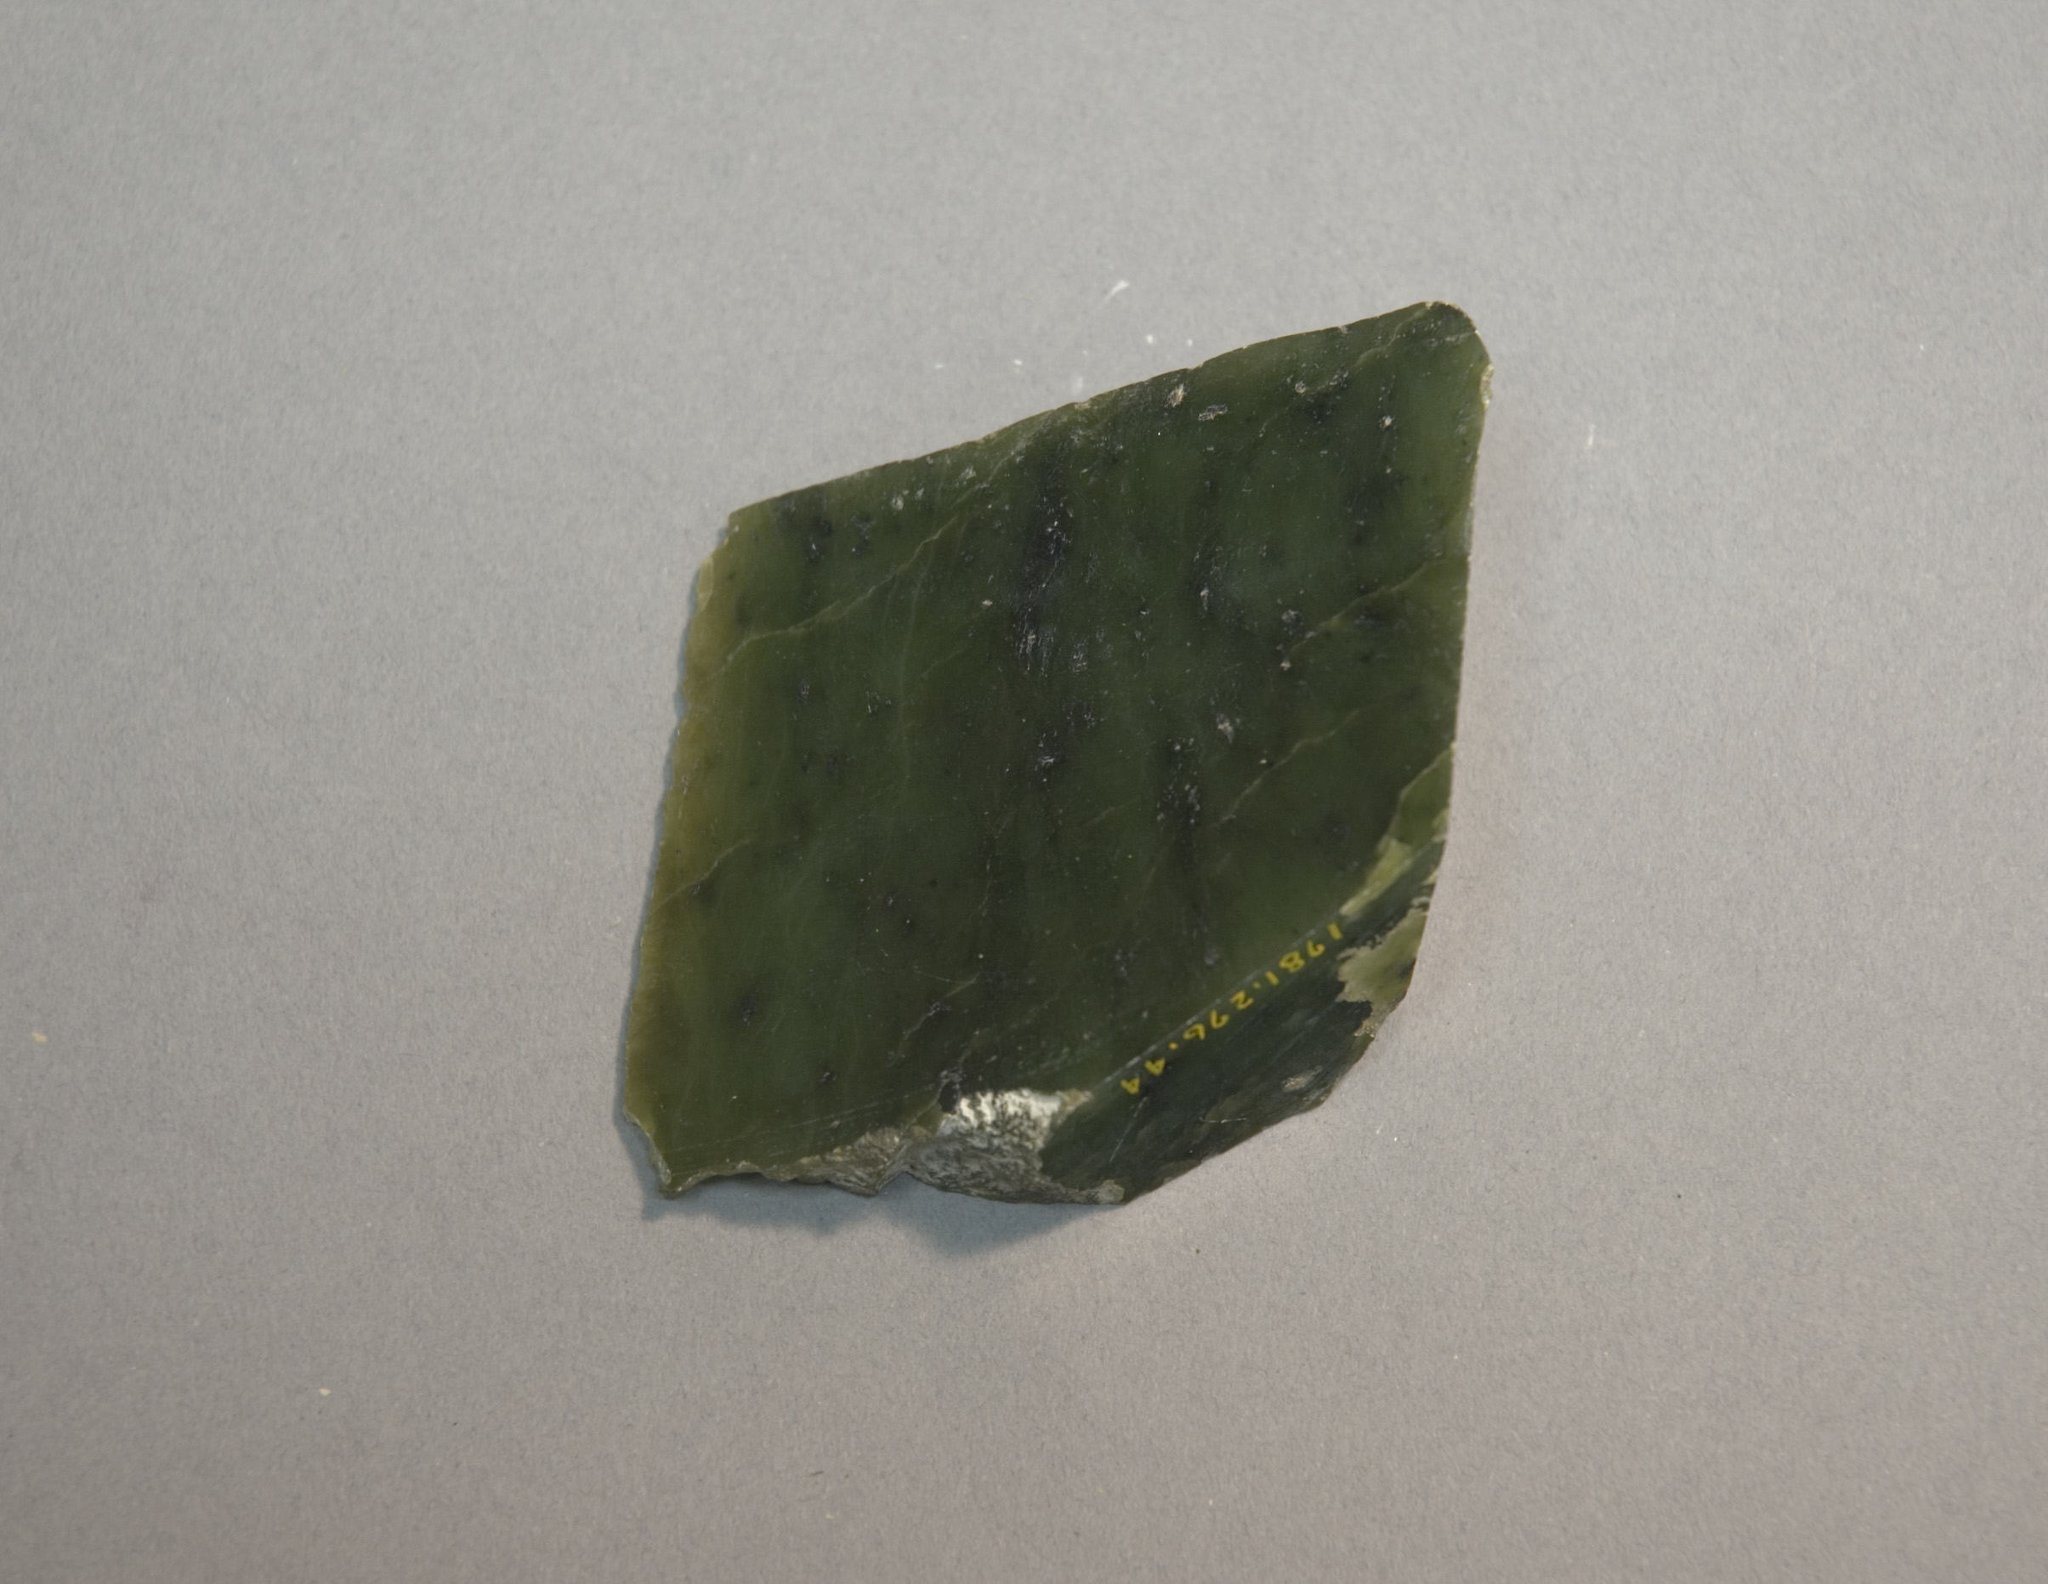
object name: jade carving material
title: Sample of "Hansford"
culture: chinese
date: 1901-2000